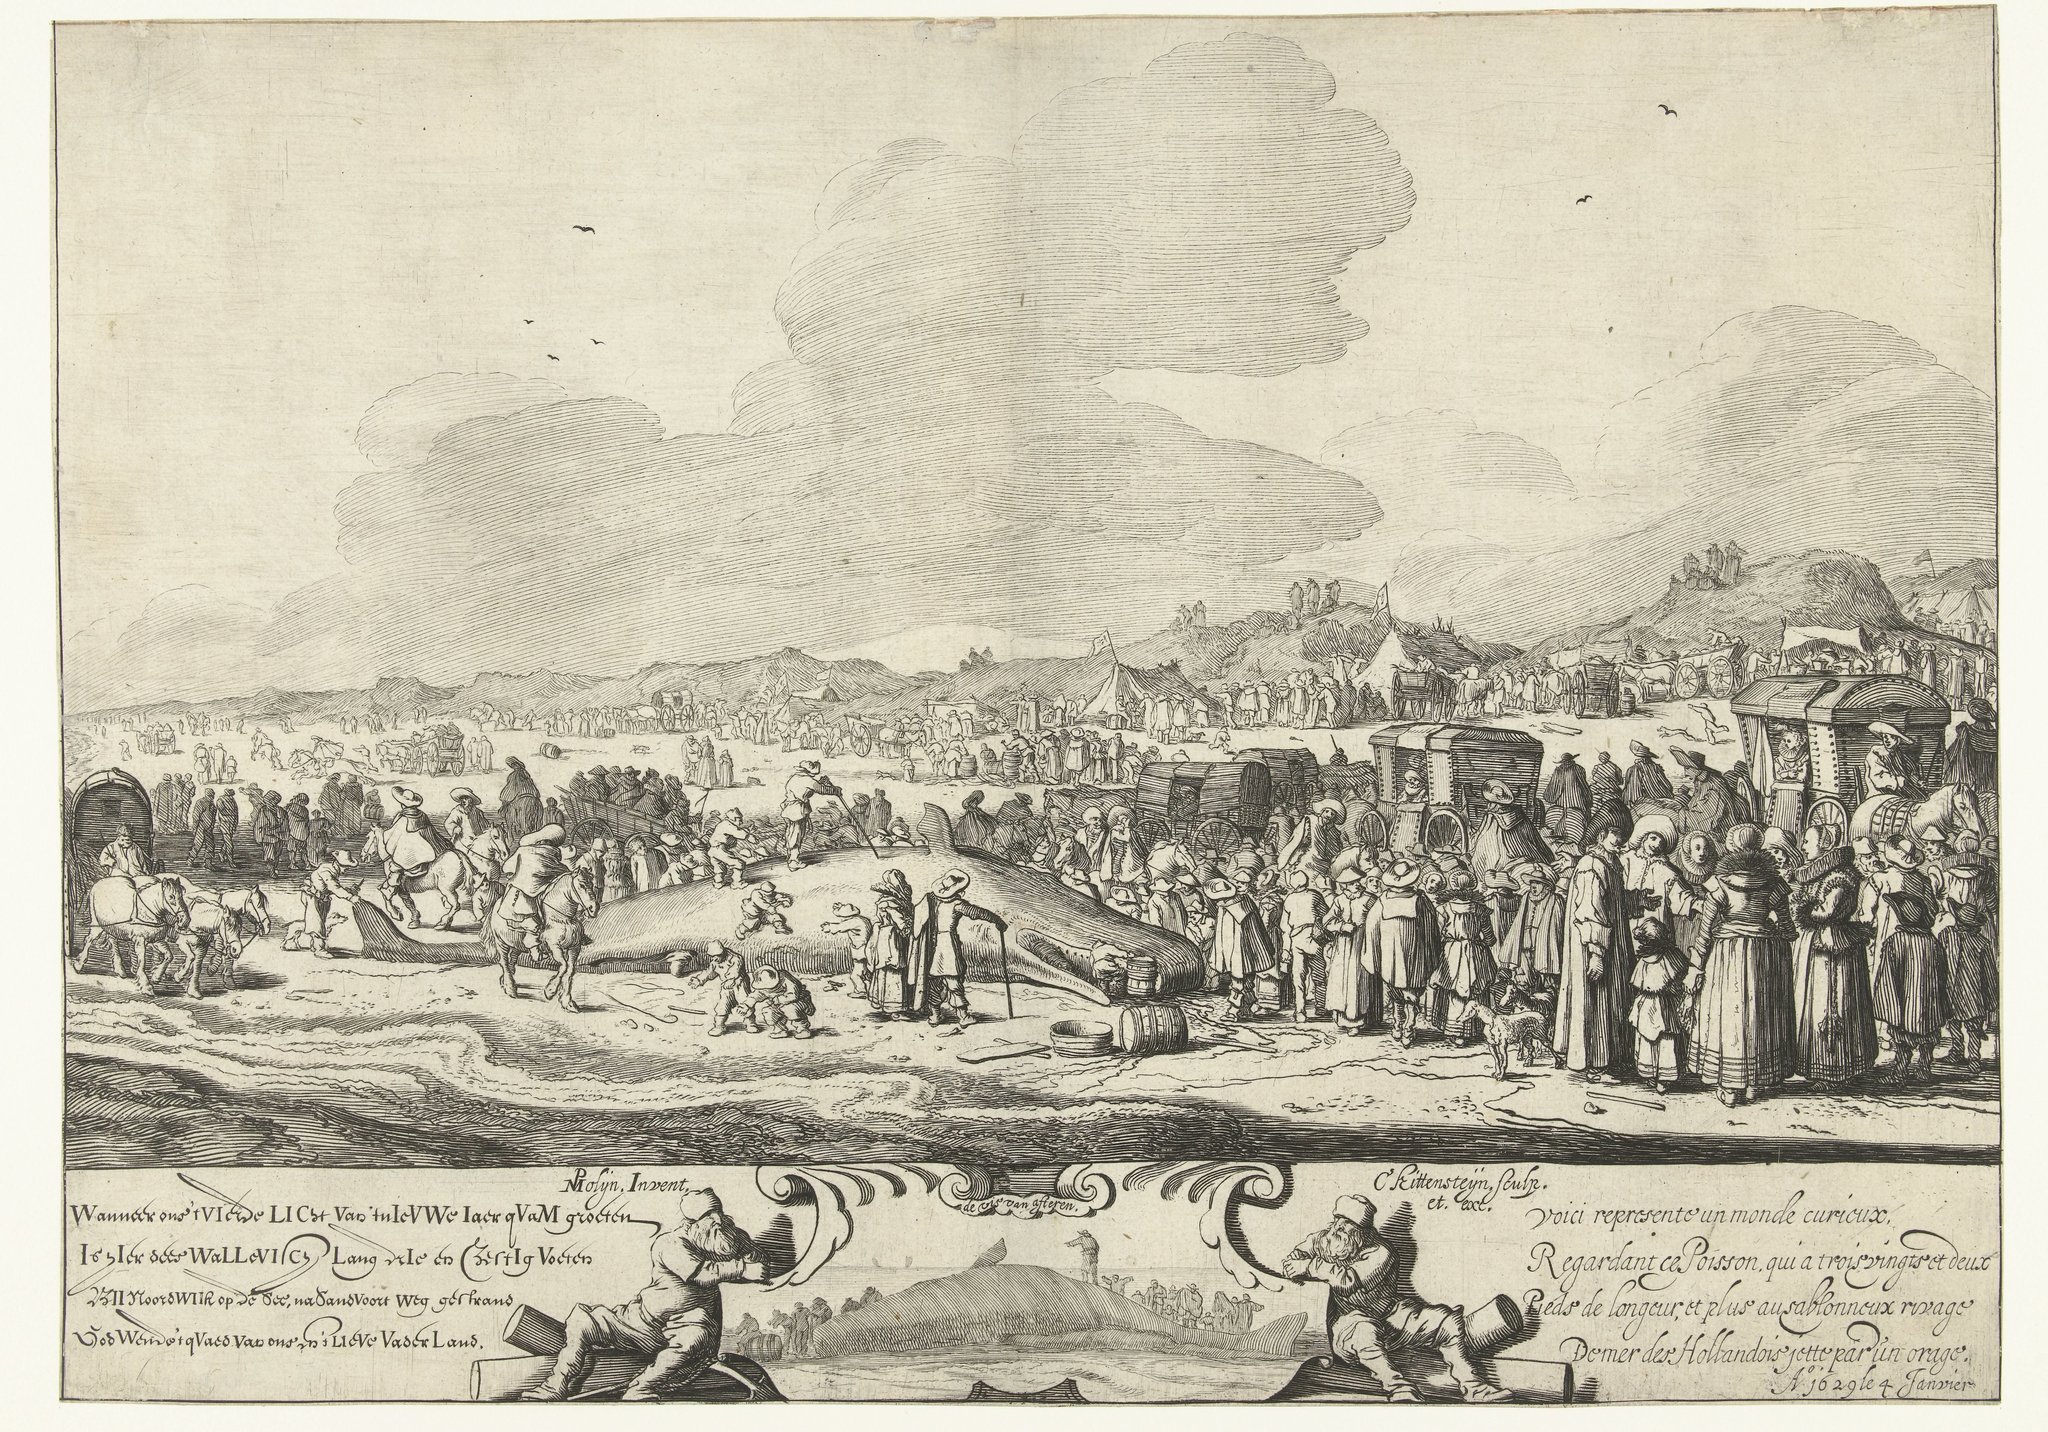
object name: print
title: Wanneer ons 't VIerde LIcht Van 't nIeVWe Iaer qVam groeten Is hIer dees WaLLeVIsCh Lang drIe en zestIg Voeten BII NoordWIIk op de see, na Sandvoort weg gestrand God Wende 't qVaed Van ons en 't LIeVe VaderLand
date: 1629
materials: paper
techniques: etching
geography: northern netherlands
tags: swimming mammals: whale (+ dying animal; death of animal; dead animal)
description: De Walvis gestrand tussen Noordwijk en Zandvoort, 4 januari 1629. Dode potvis liggend op het strand. Met veel bezoekers en koetsen op het strand, op de achtergrond de duinen. Onderaan een gezicht op de walvis van achteren met twee vissers aan weerszijden. Met links en rechts onderschriften in het Nederlands (een tijdvers) en Frans.